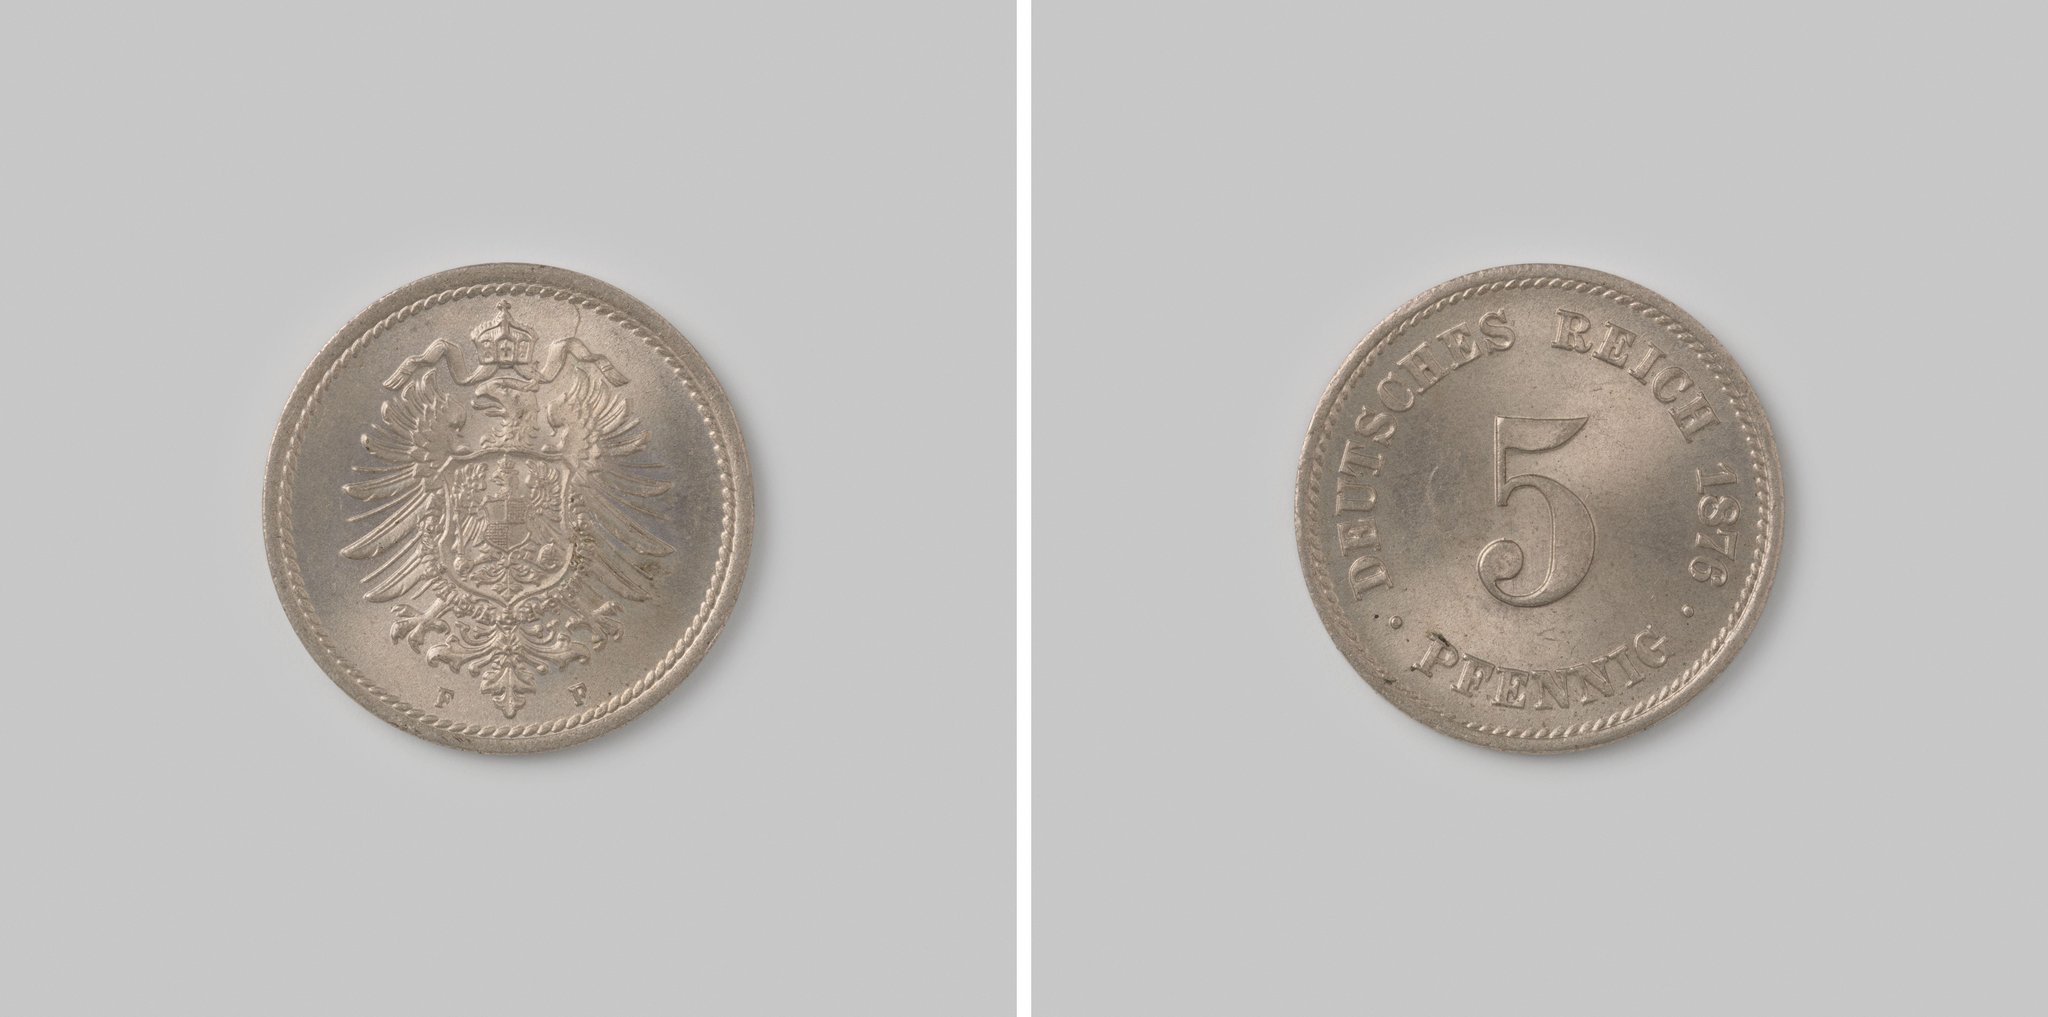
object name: coin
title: 5 Pfennig uit het Duitse Rijk, 1876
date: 1876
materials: nickel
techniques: striking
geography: stuttgart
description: Nikkelen munt. Voorzijde: gekroonde enkelkoppige adelaar naar links met op borst door keten van orde met juweel omhangen samengesteld wapenschild. Daaronder twee letters F. Keerzijde: waarde-aanduiding in twee regels. Jaartal in omschrift. Gladde rand.